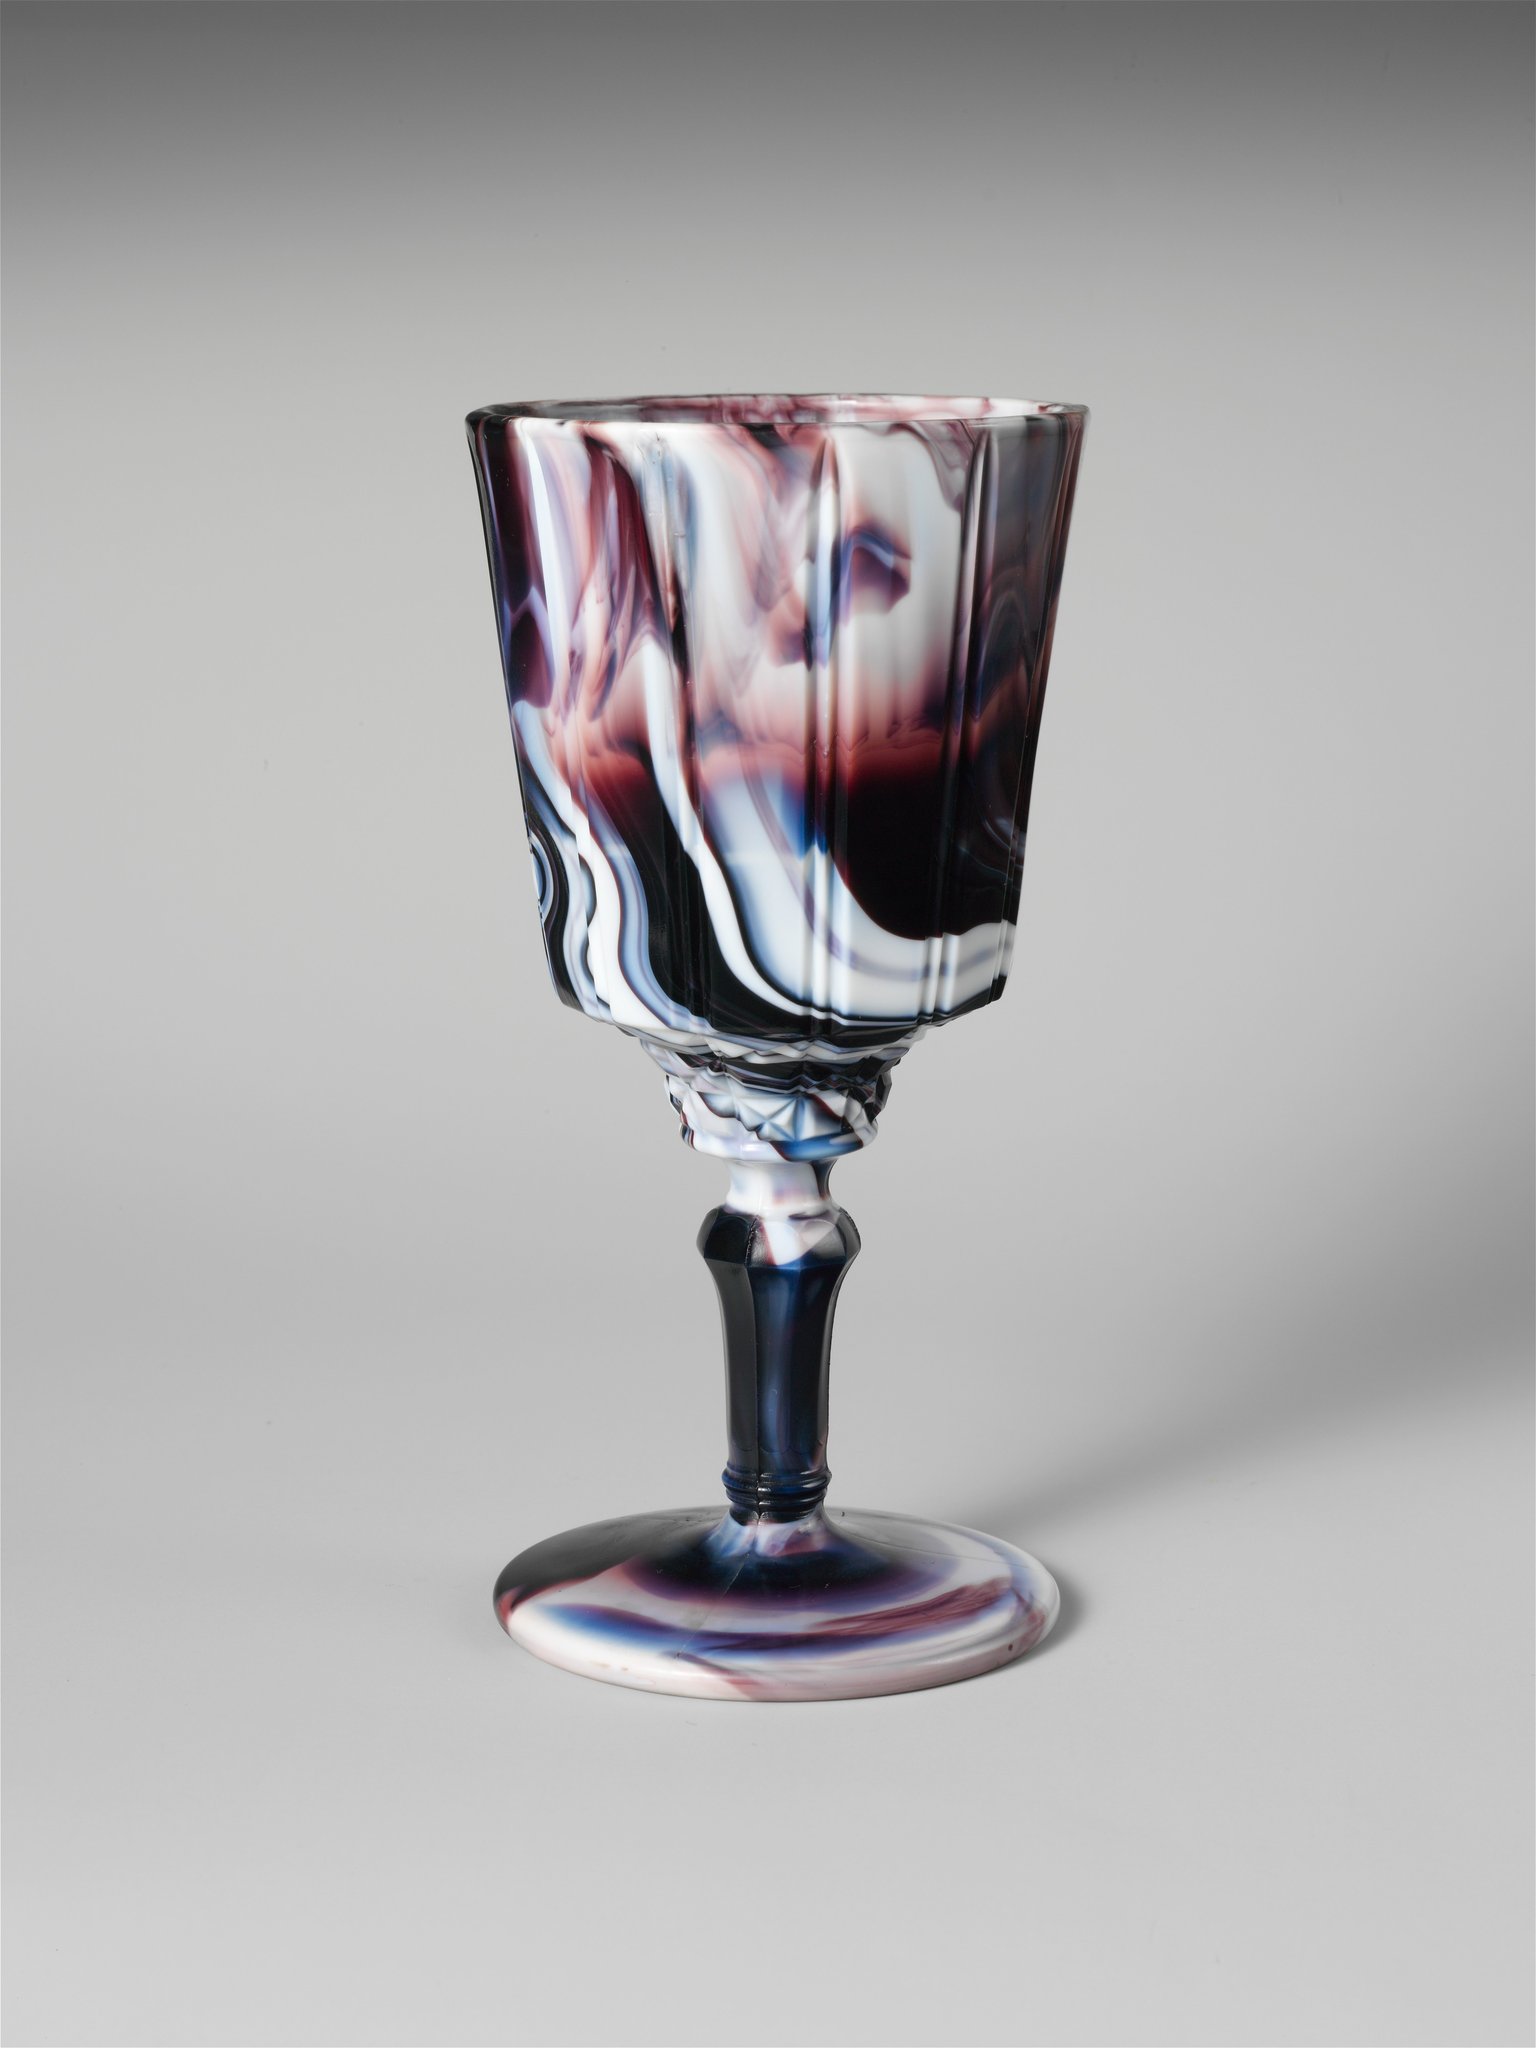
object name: goblet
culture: american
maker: challinor, taylor and company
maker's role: maker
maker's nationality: american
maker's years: 1866-1891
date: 1870-1890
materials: glass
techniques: pressed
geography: united states